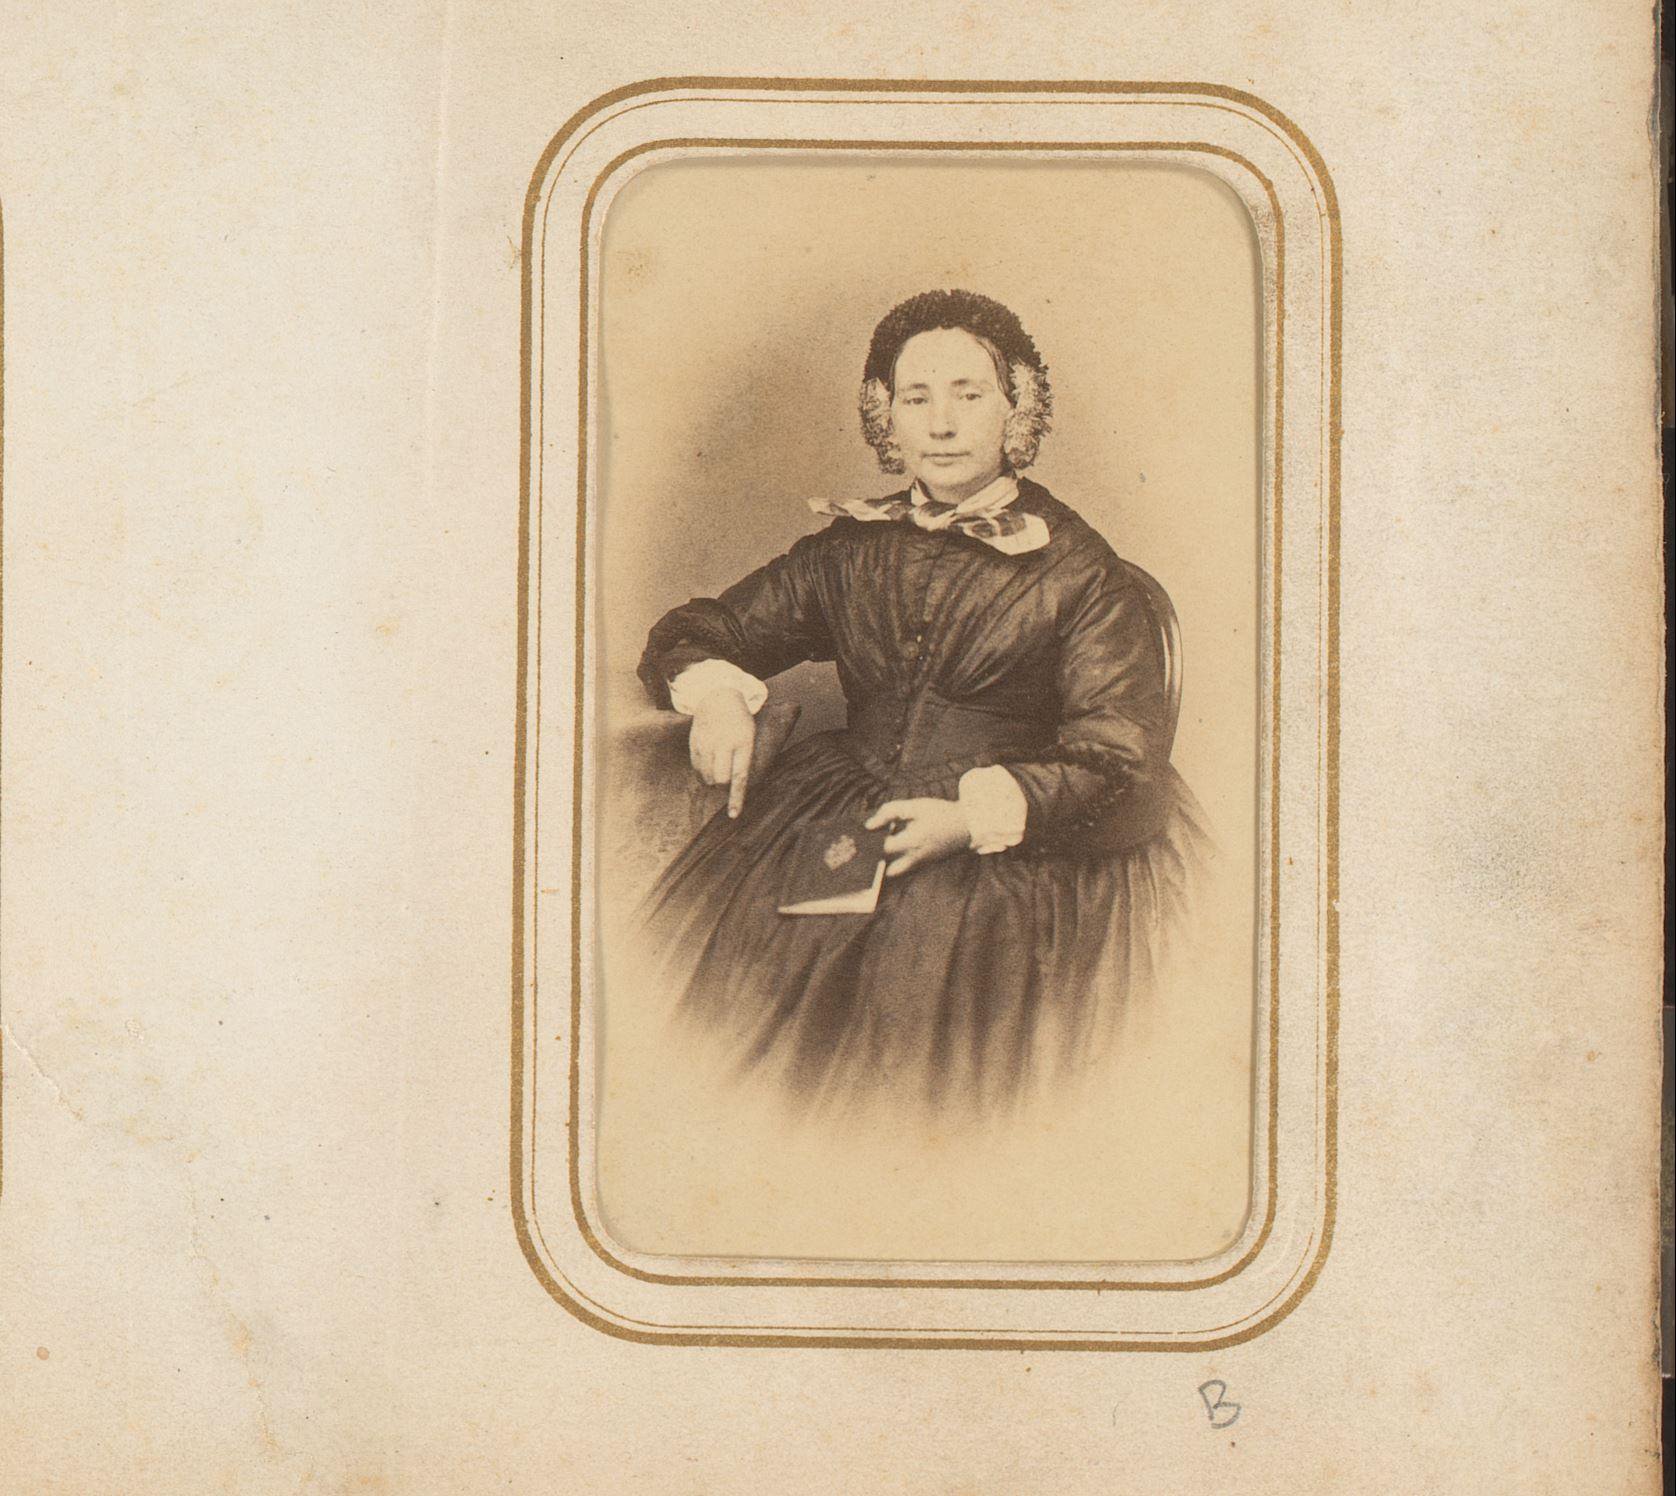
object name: photograph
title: Portret van een vrouw, aangeduid als Johanna Hermina van Dreeven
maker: johannes peter metzger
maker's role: fotograaf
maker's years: 1830-1867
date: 1850-1867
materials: cardboard, photographic support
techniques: albumen print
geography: utrecht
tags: historical persons - bb - woman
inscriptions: inscription: ‘J.P Metzger/ Photographe/ Utrecht’, annotation: ‘No.2 (bl2)/ Mijn moeder/ Johanna Hermina van Dreeven/ + 4 oct 1867/ [...] [13] jaar’